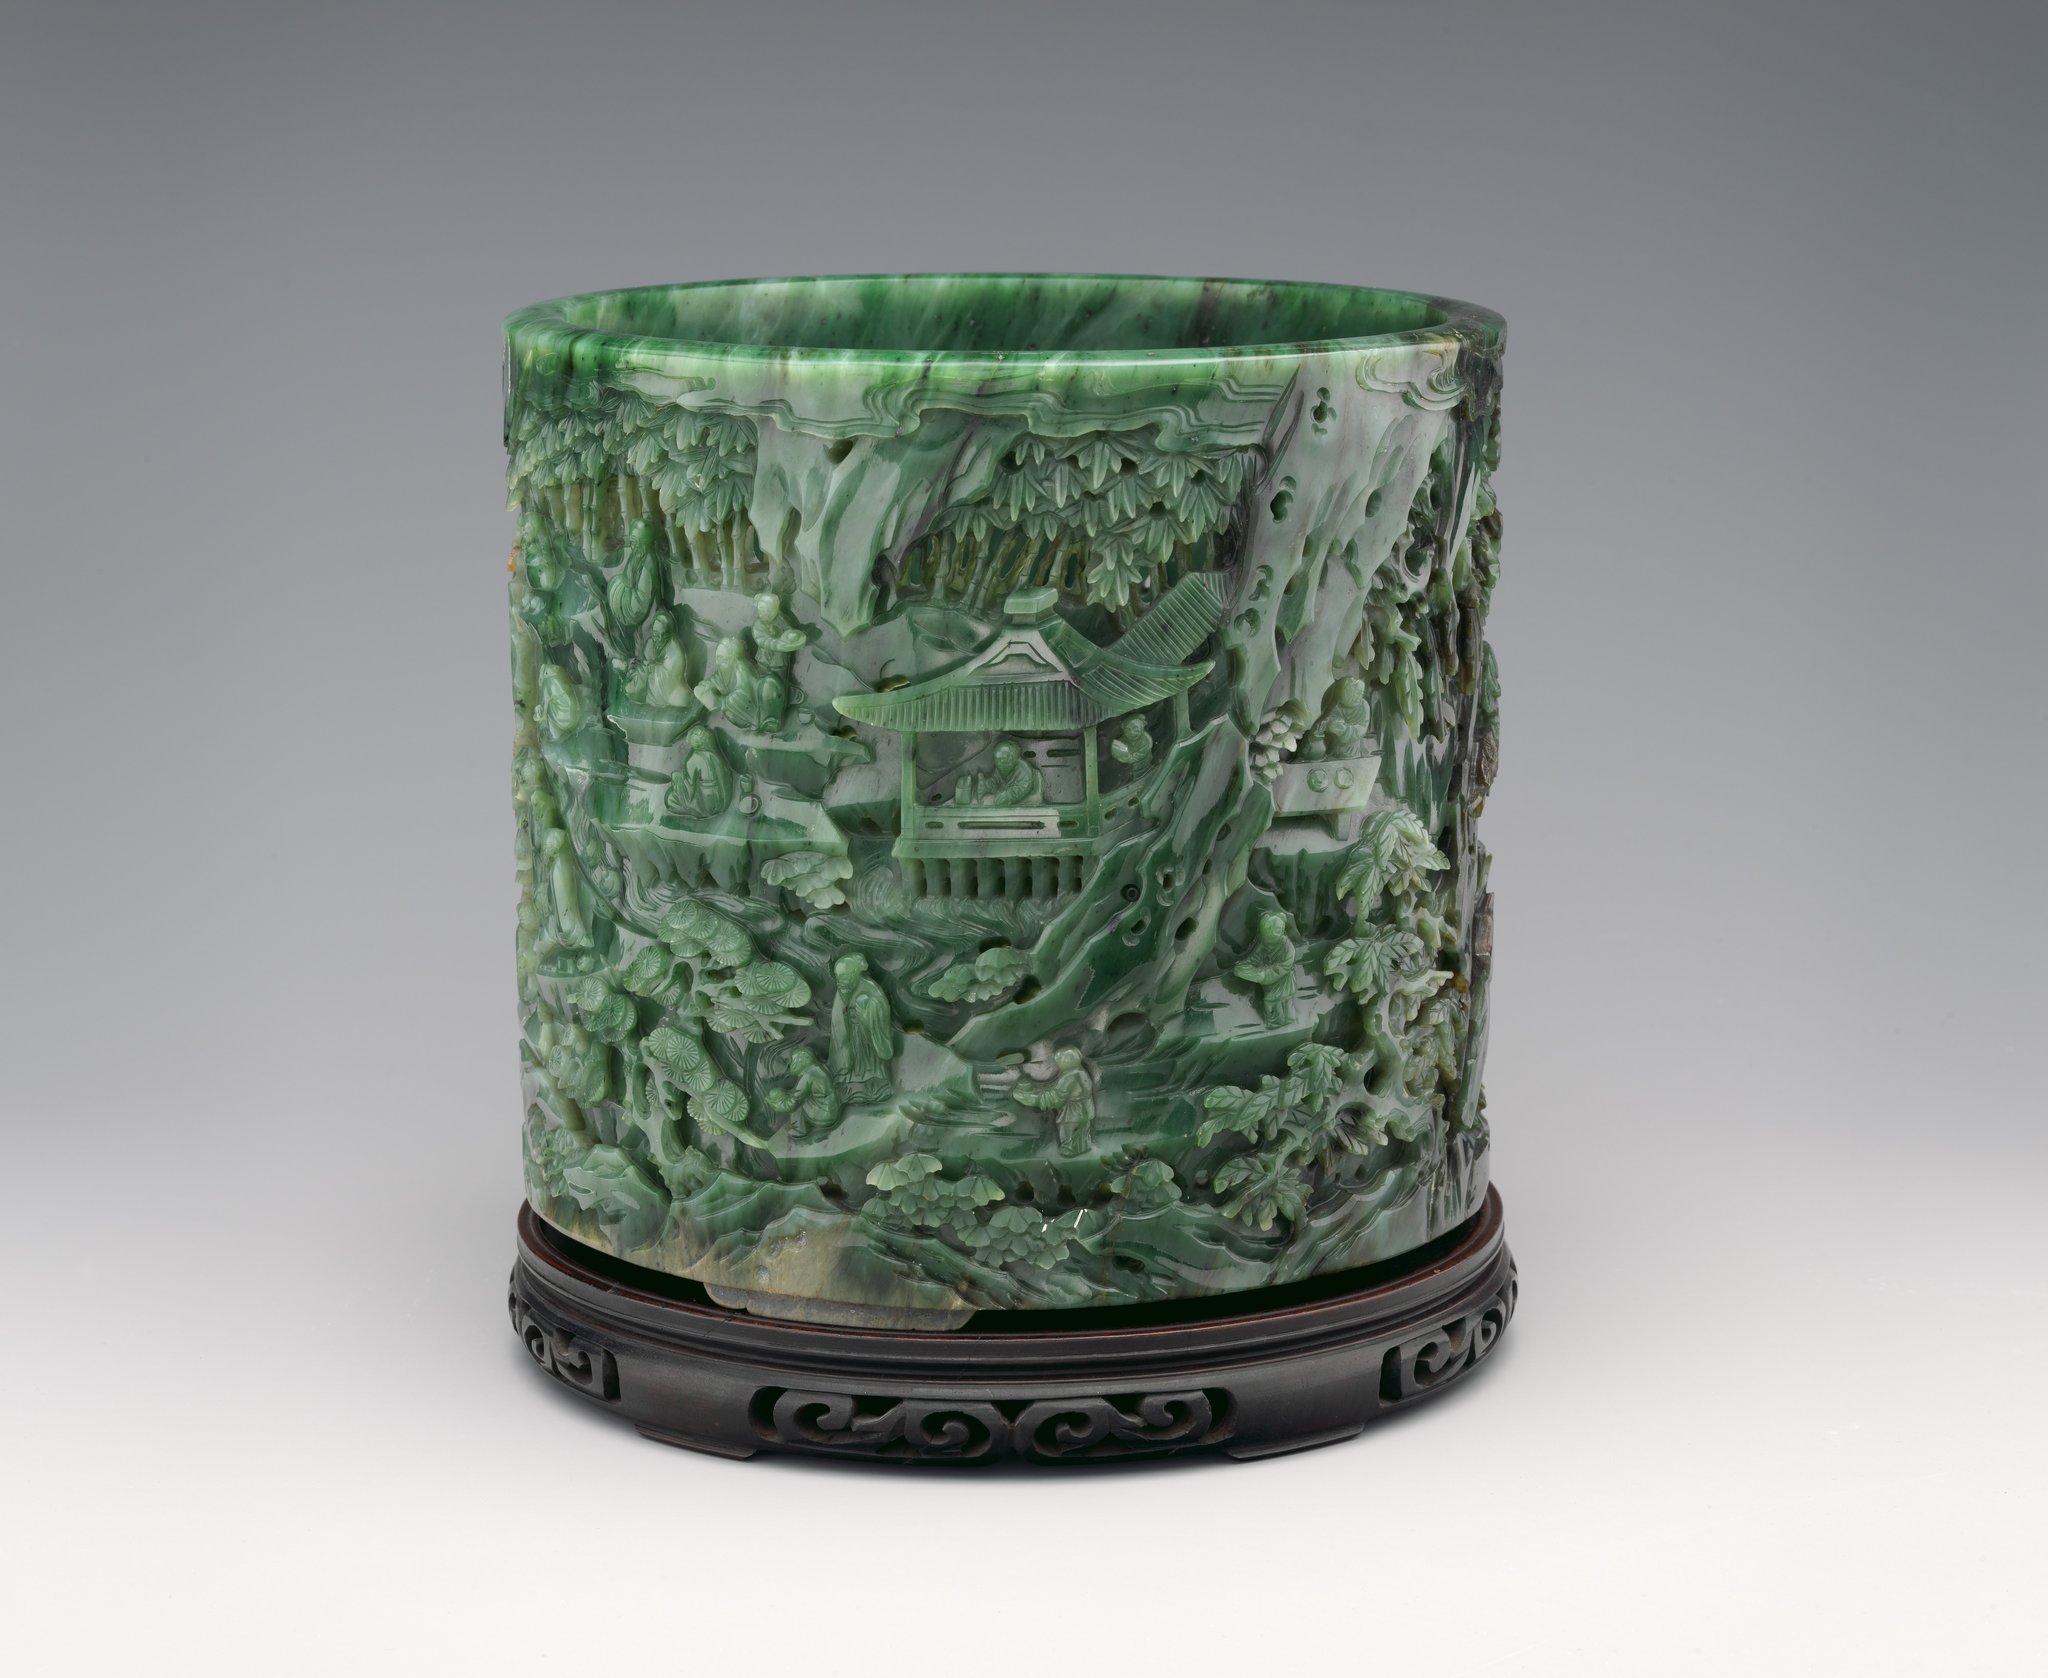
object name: brush holder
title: Brush holder with Gathering at the Orchid Pavilion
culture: chinese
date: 1701-1900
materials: jade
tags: human figures,orchids